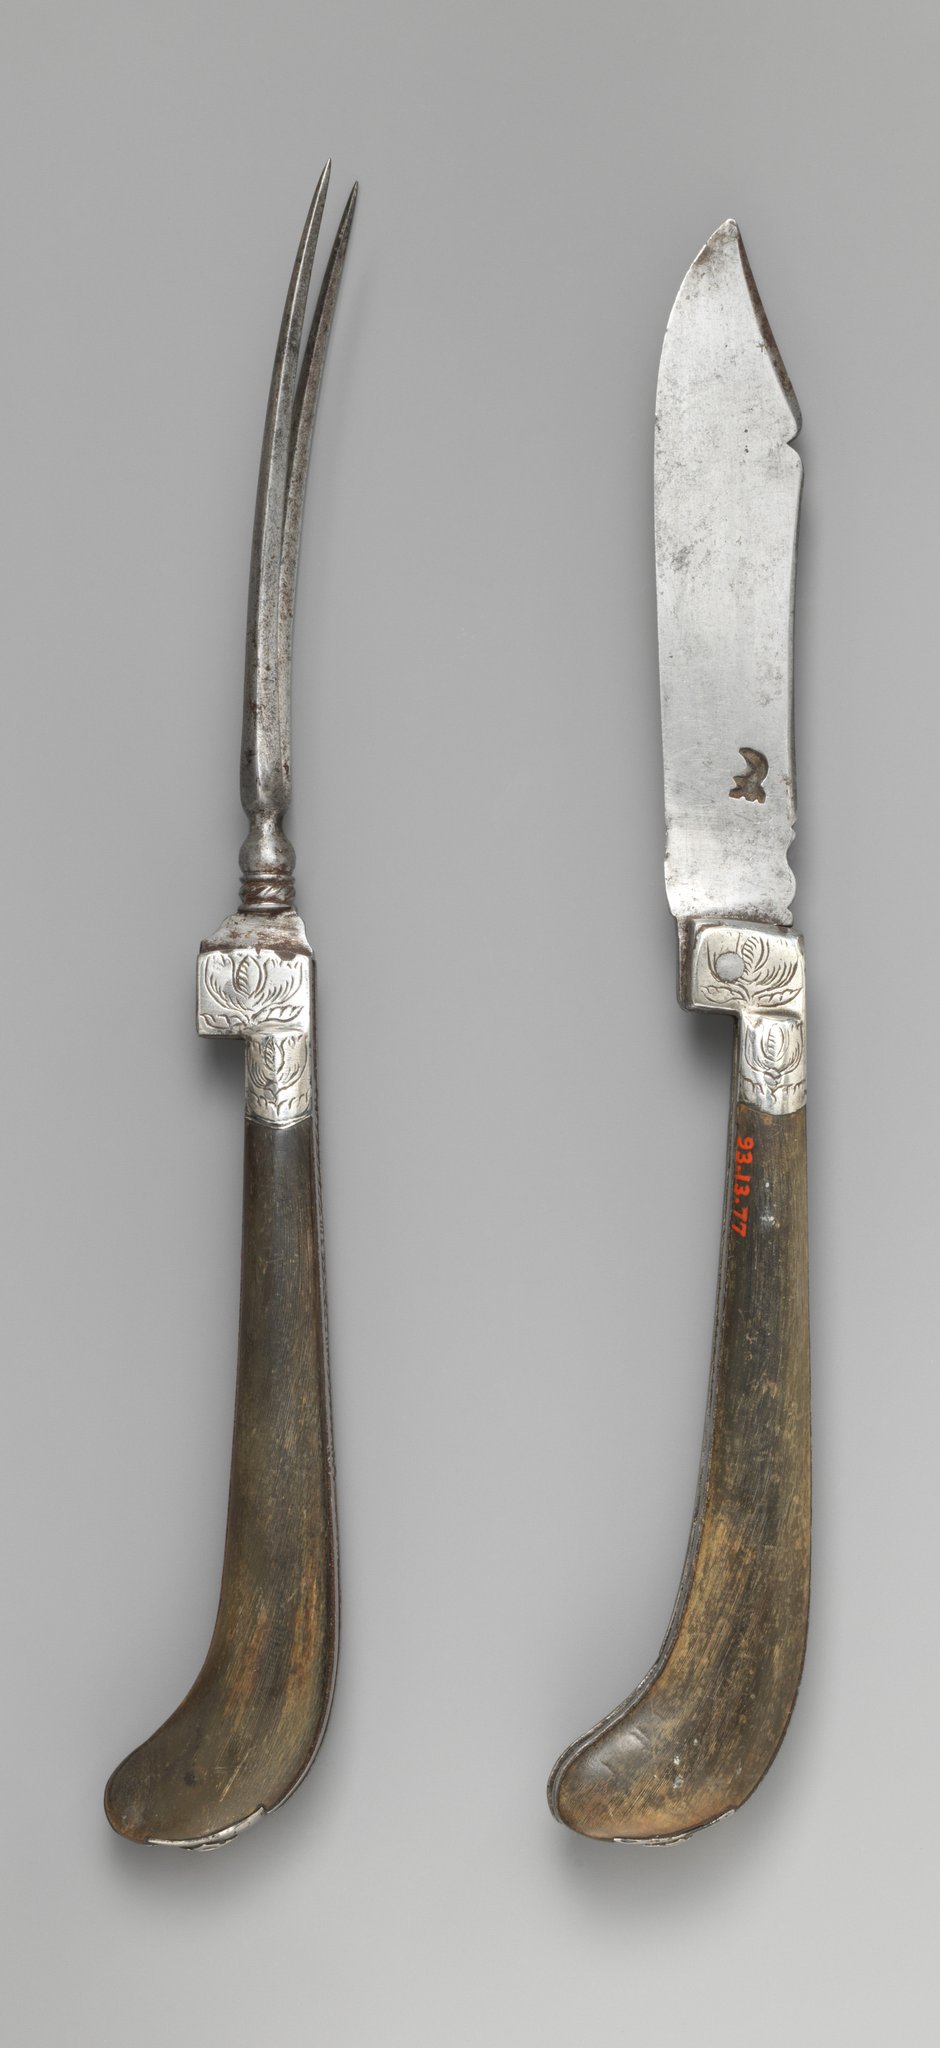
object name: table fork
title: Folding table fork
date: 1701-1800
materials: silver, steel